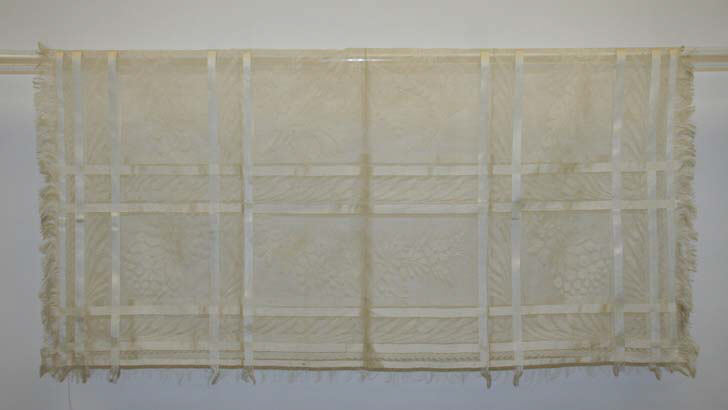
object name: scarf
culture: american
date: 1801-1833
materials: silk